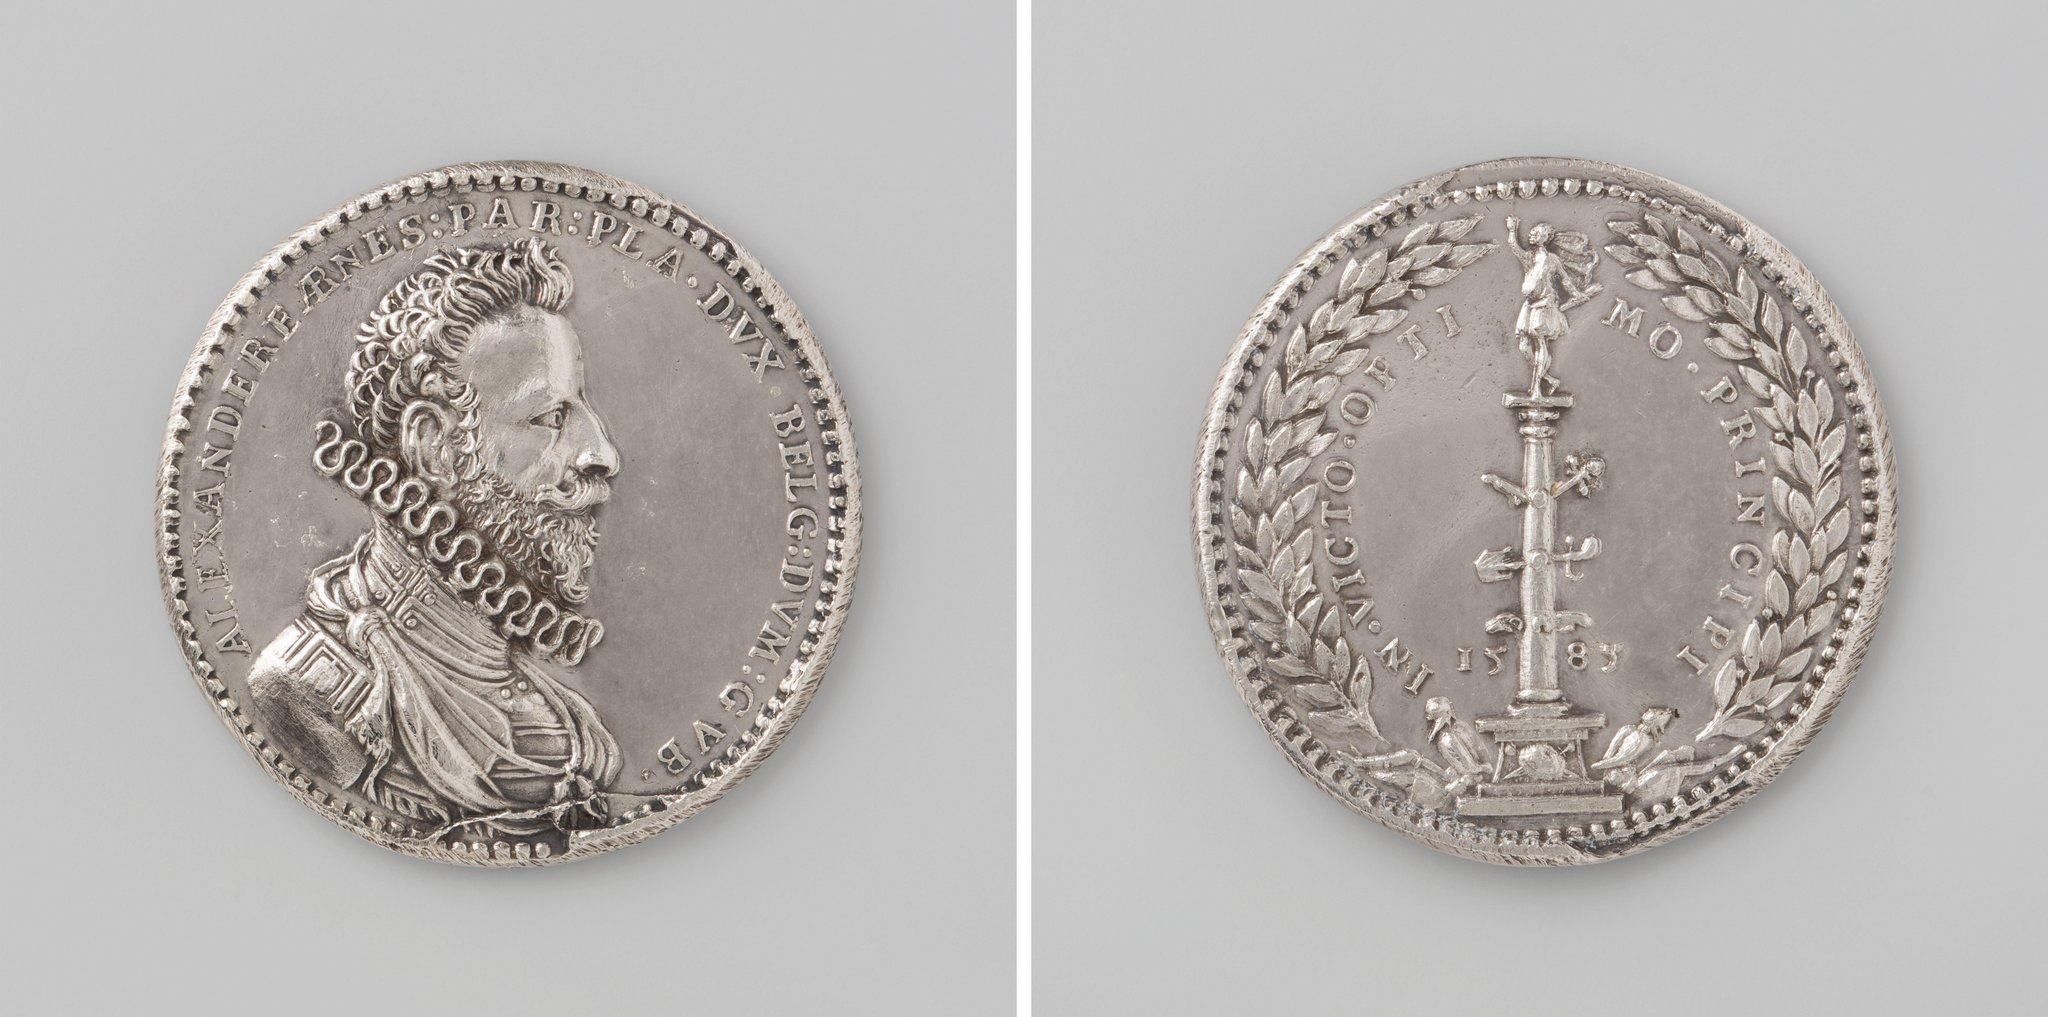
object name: history medal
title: Erezuil opgericht voor de hertog van Parma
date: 1585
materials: silver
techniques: striking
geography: antwerp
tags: vienna, albert casimir van saksen-teschen, rome, alessandro farnese (landvoogd van de nederlanden en hertog van parma en piacenza)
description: Zilveren penning. Voorzijde: borststuk man binnen omschrift. Keerzijde: erezuil tussen jaartal binnen omschrift en lauwerkrans.